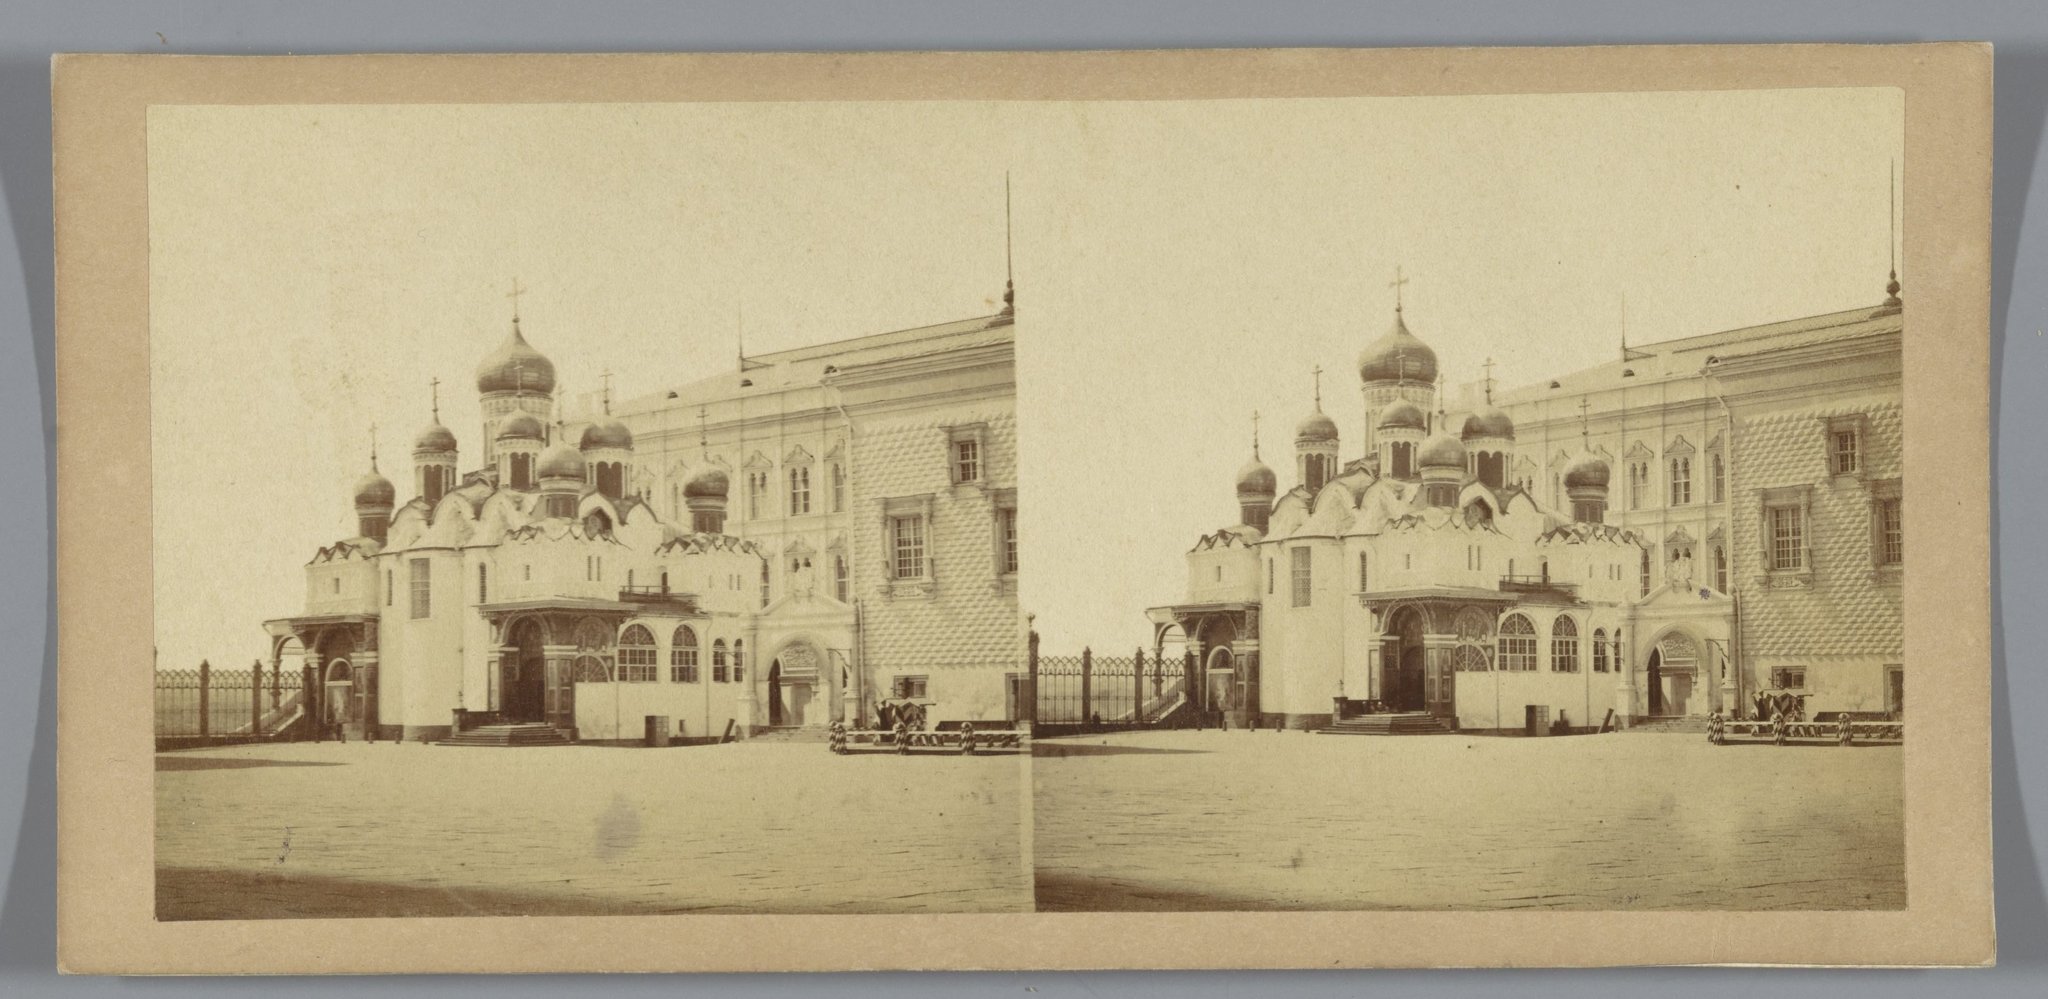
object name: stereograph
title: Gezicht op de Verkondigingskathedraal van het Kremlin in Moskou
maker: Anonymous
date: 1850-1880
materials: cardboard, photographic support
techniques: albumen print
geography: moscow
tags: church (exterior)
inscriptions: inscription: ‘D.9.’, inscription: ‘l'Annonciation en Kremlin’